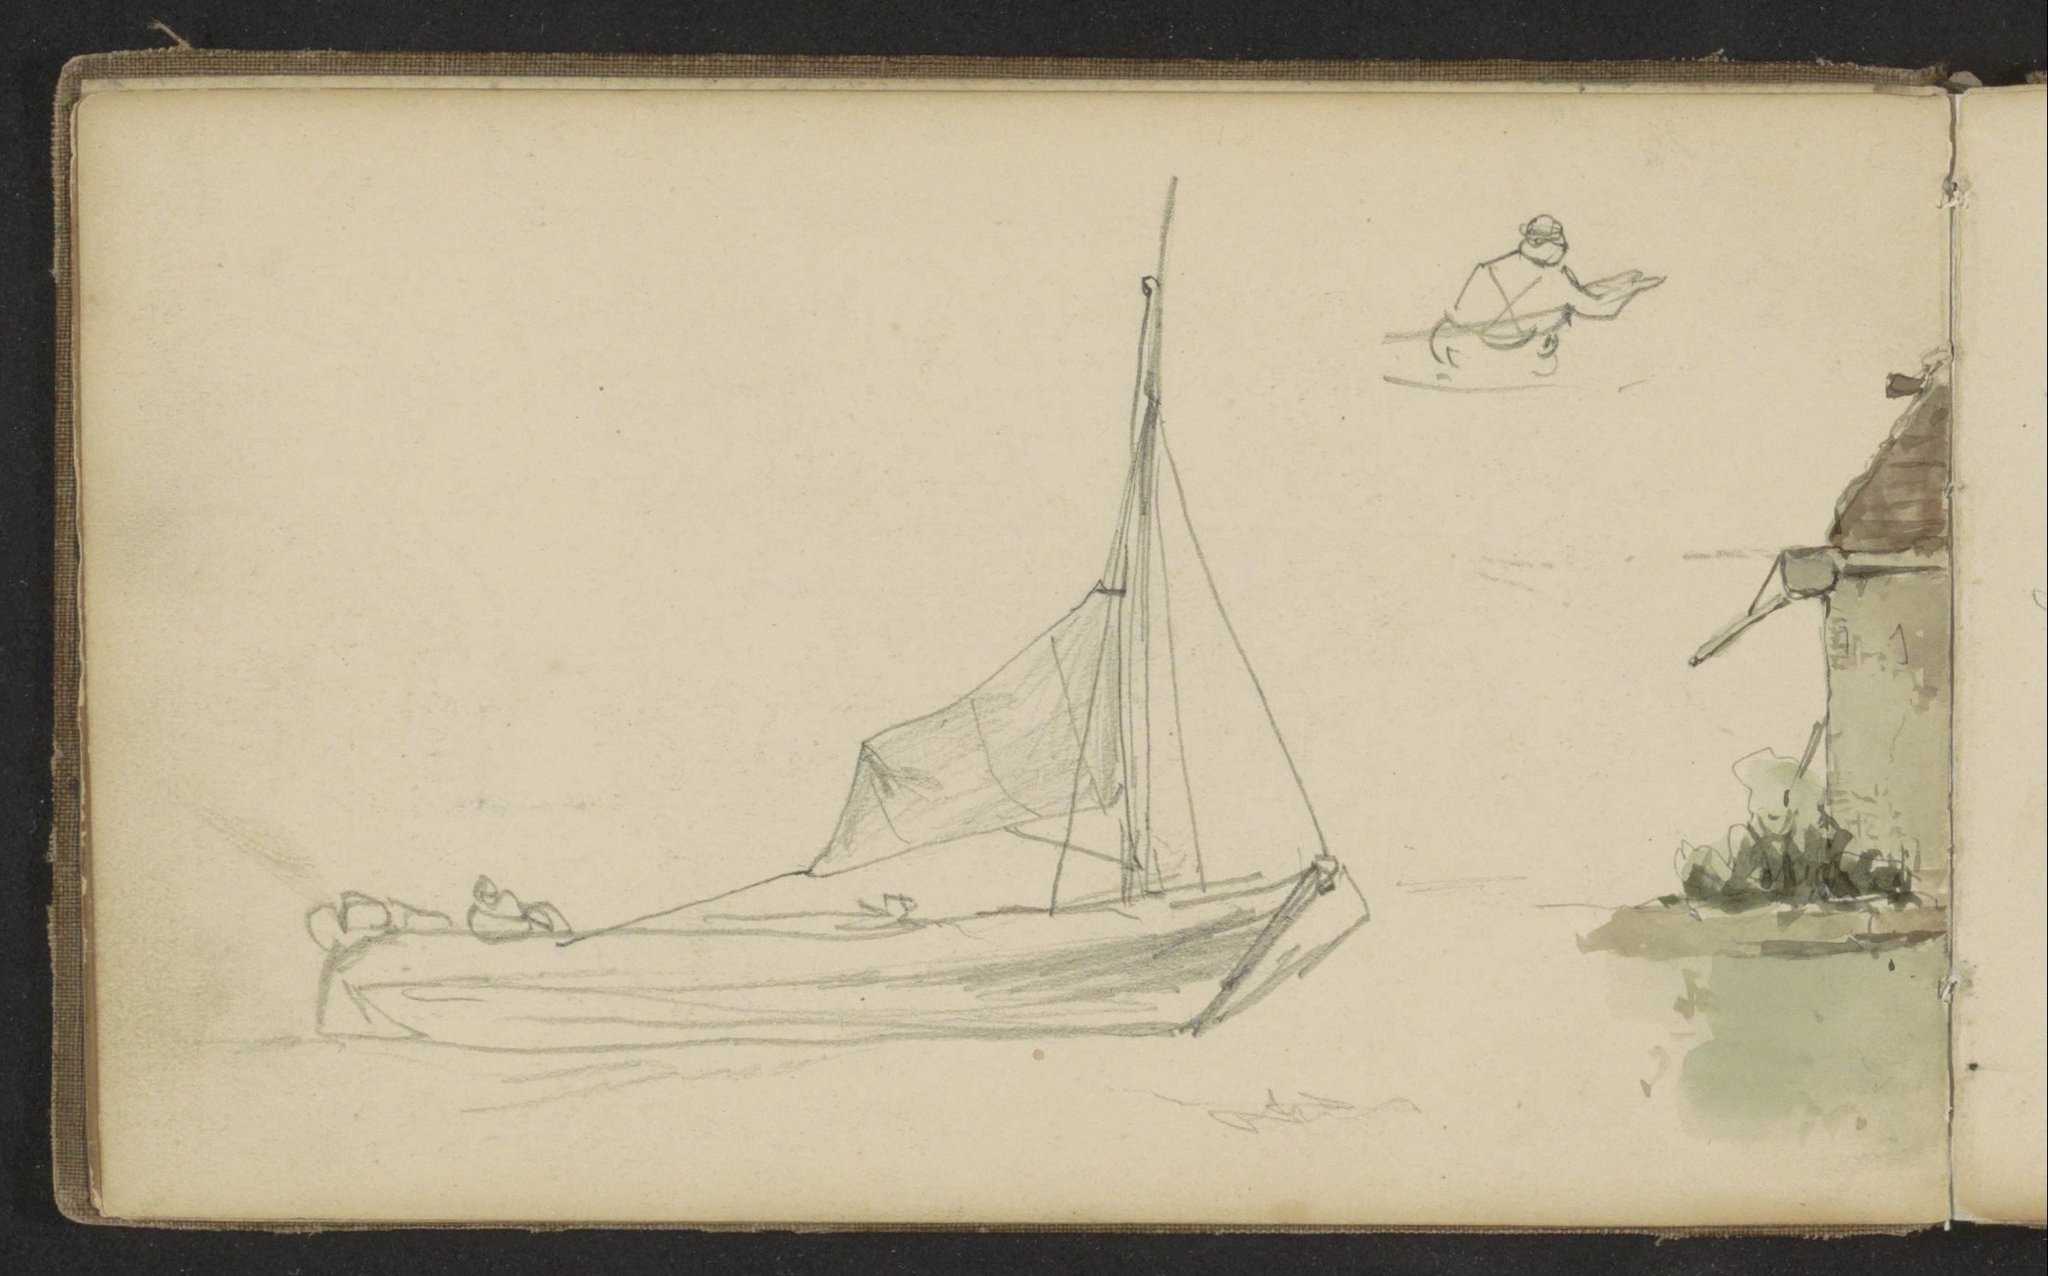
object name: sketchbook leaf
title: Zeilboot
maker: johan hendrik weissenbruch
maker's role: draughtsman, painter, print maker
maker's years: 1824-1903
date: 1834-1903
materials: paper, pencil, watercolor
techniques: brush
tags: sailing-ship, sailing-boat, cottage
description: Tevens een studie van een stuk muur en dak van een huis en van een zittende man. Mogelijk heeft hij een roeispaan vast. Blad 2 verso uit een schetsboek met 43 bladen.